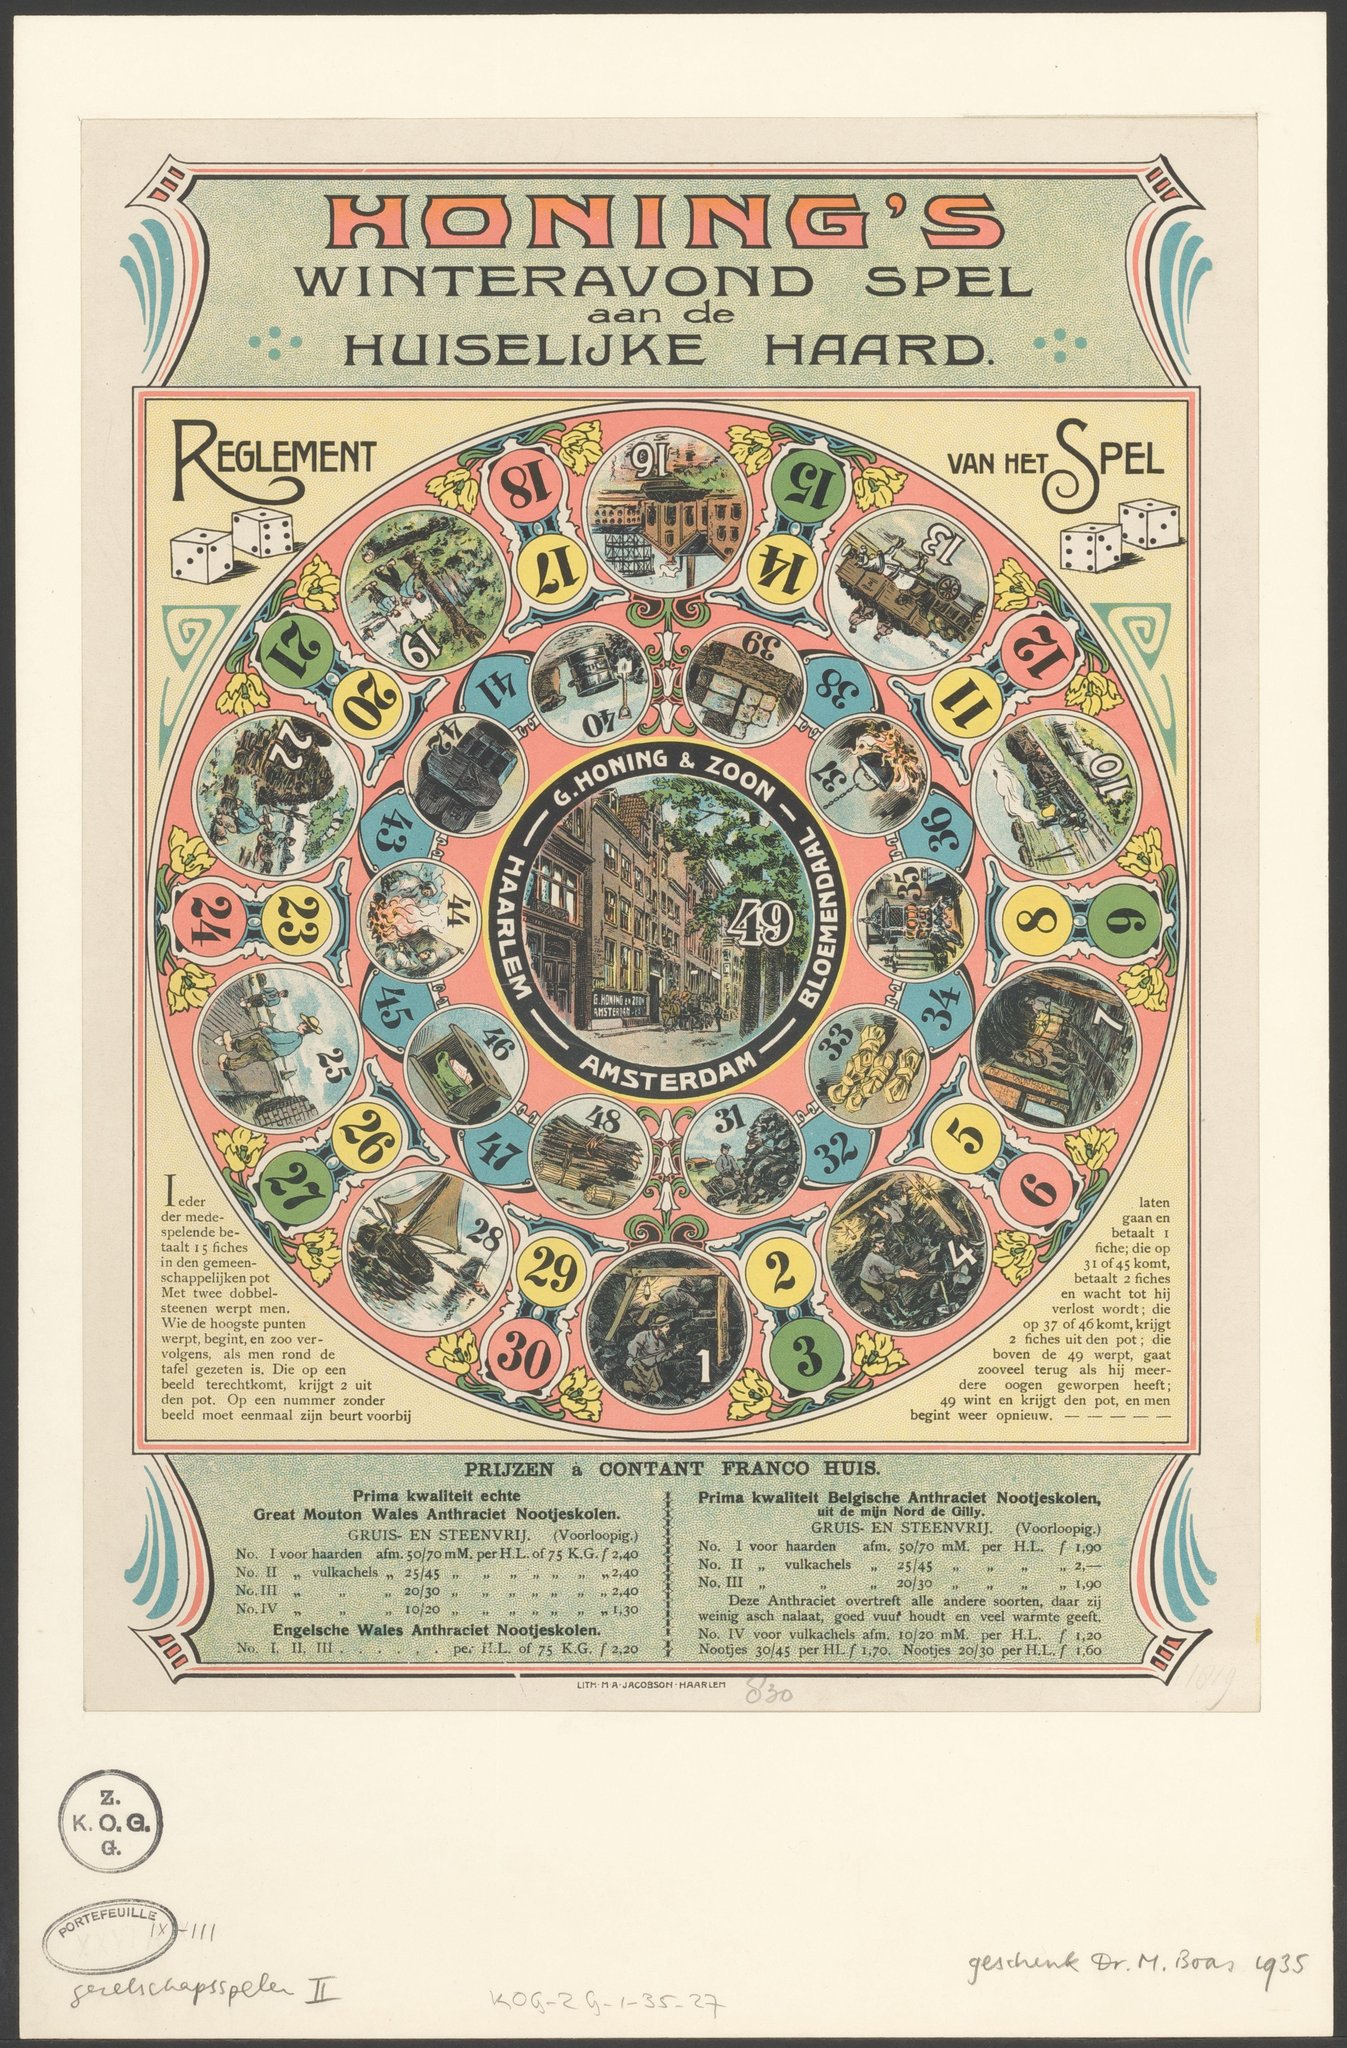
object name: print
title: Honing's winteravond spel aan de huiselijke haard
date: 1900-1949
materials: paper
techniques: photolithography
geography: haarlem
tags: board-games, winter solstice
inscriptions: stamp, collector's mark: Lugt 1641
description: Bordspel met in 49 vakken voorstellingen met betrekking tot de winning, het vervoer en het gebruik van brandstoffen, uitgegeven door de firma G. Honing & Zoon, handelaars in brandstoffen. In het midden, in vak 49, een afbeelding van het gebouw van de firma Honing aan het Singel 19-21 in Amsterdam. Op verso de prijscourant. Onderwerpsrubrieken binnen de Atlas Zeden en Gewoonten: Zeden en gewoonten in engeren zin, Spel en vermaak, Gezelschapsspel II, Ganzenbord en dergelijke.